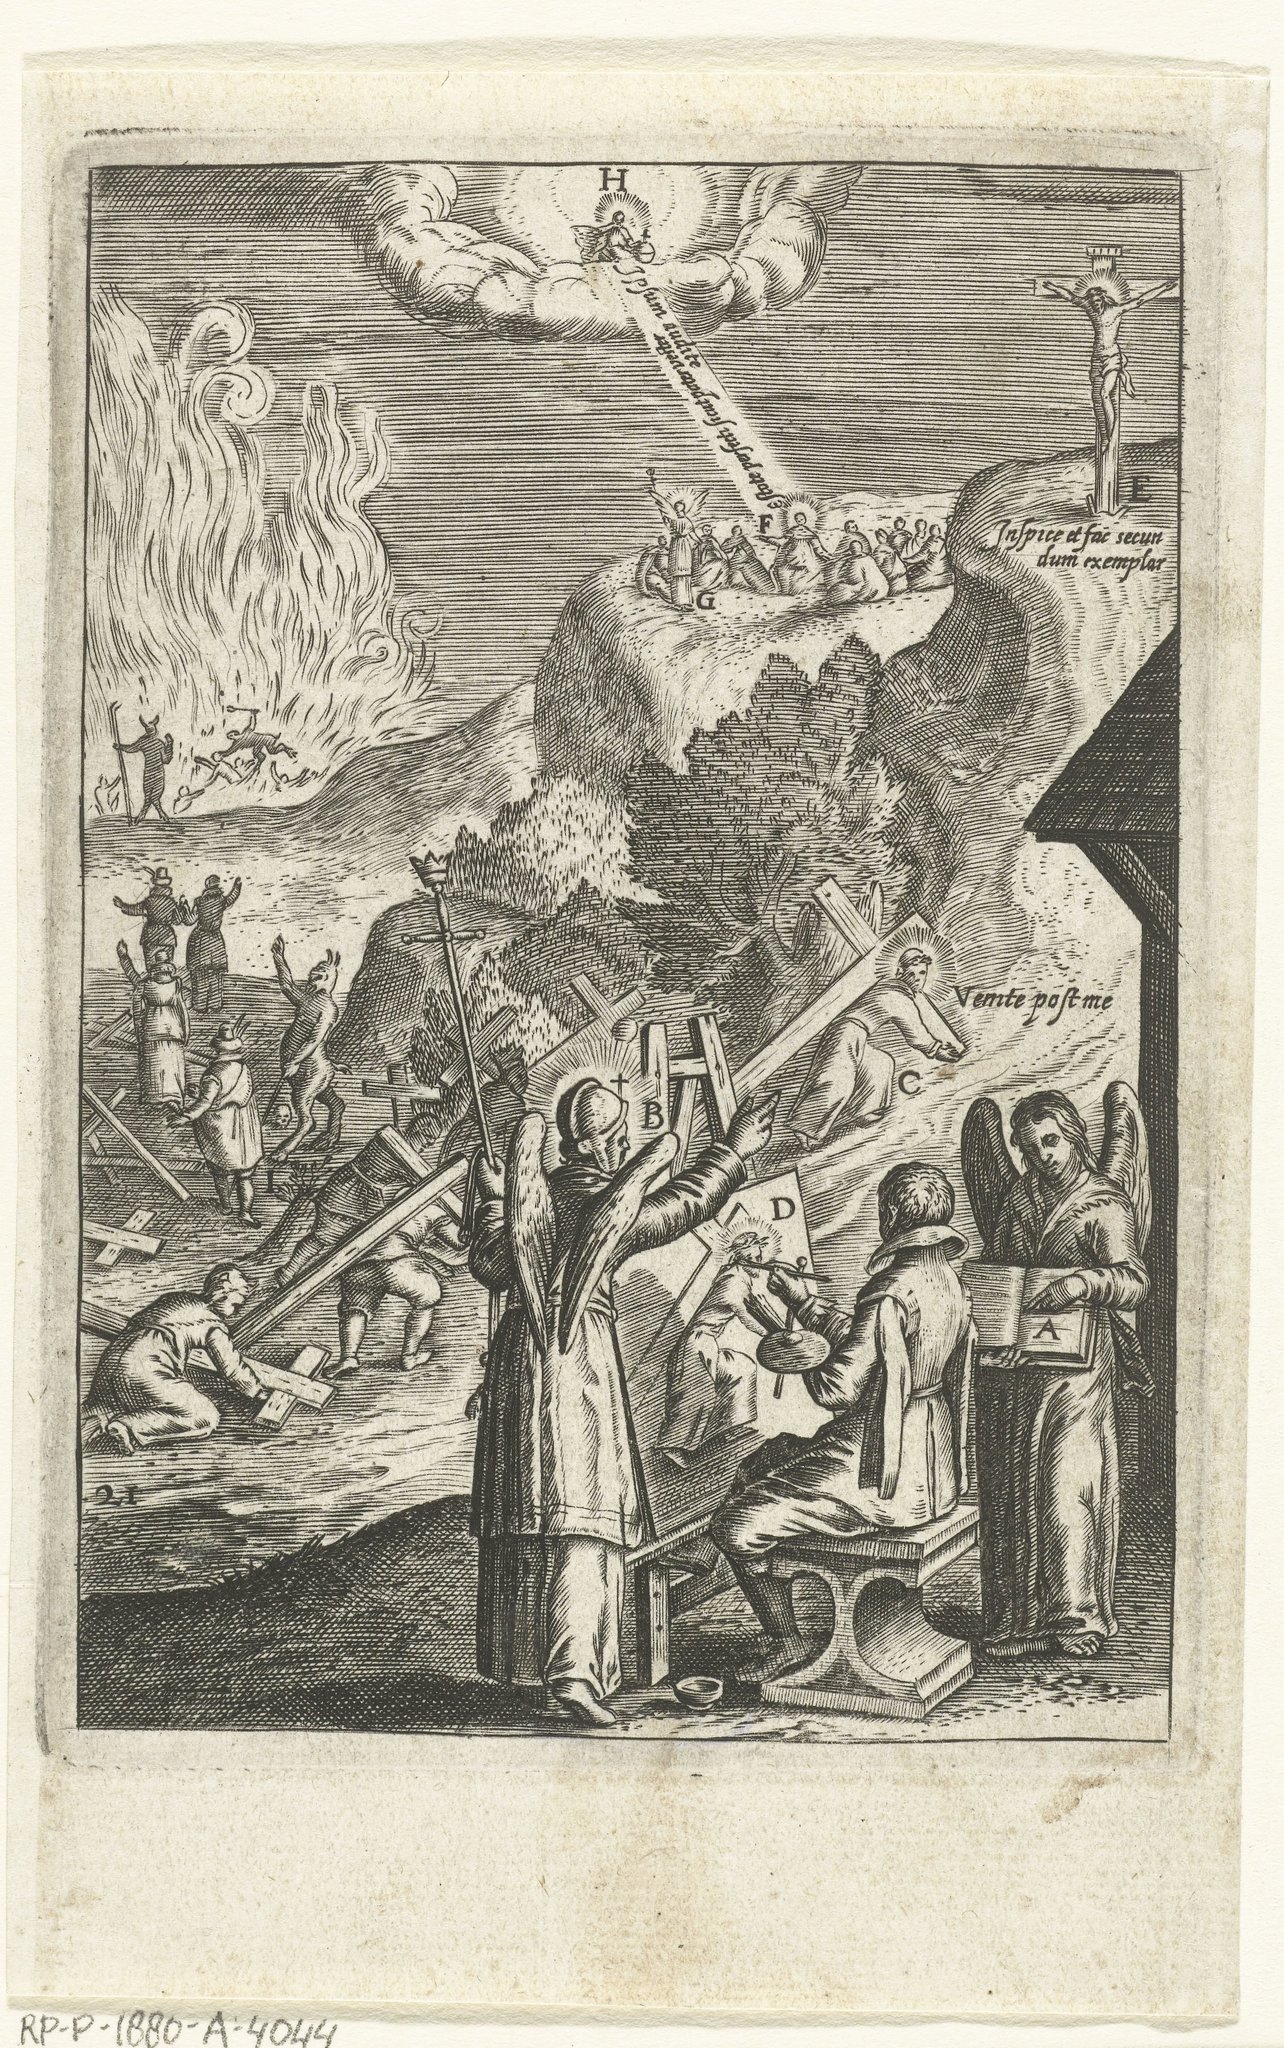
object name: print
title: Den wech des eeuwich levens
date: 1620-1623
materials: paper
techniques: engraving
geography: antwerp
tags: the life of man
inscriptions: collector's mark: Lugt 2228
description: Een man schildert op aanwijzing van een engel het portret van Christus op de kruisweg. De man stelt daarmee een voorbeeld voor zichzelf hoe ook hij in deugd kan leven, aldus het meditatievoorschrift in de uitgave. In het landschap draagt Christus zijn kruis de Calvarieberg op en velen volgen hem met een eigen kruis.